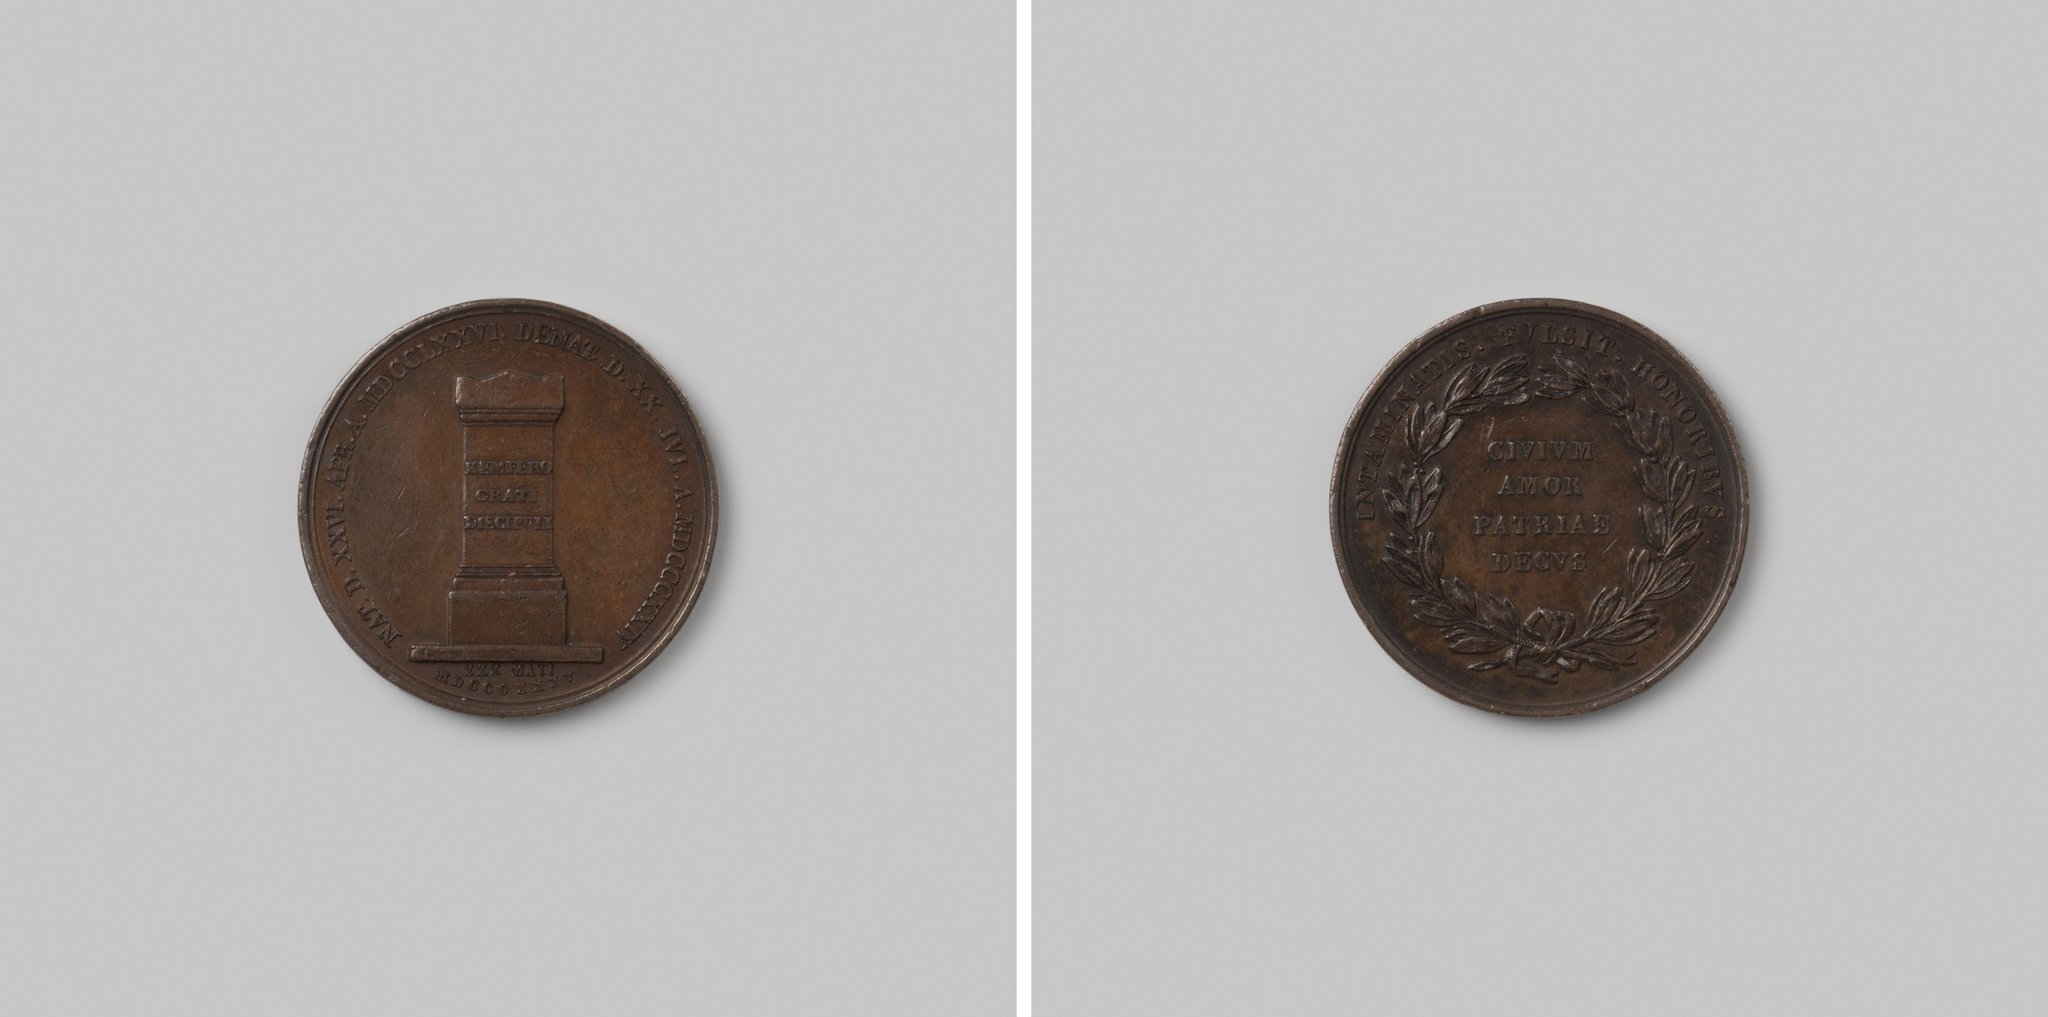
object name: history medal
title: Oprichting van een monument voor Joan Melchior Kemper in de St. Pieterskerk te Leiden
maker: johan philip menger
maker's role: medailleur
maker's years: 1818-1895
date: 1835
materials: bronze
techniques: striking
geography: utrecht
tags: jonkheer joan melchior kemper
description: Bronzen penning. Voorzijde: monument met opschrift binnen omschrift; afsnede: datering. Keerzijde: opschrift binnen lauwerkrans en omschrift